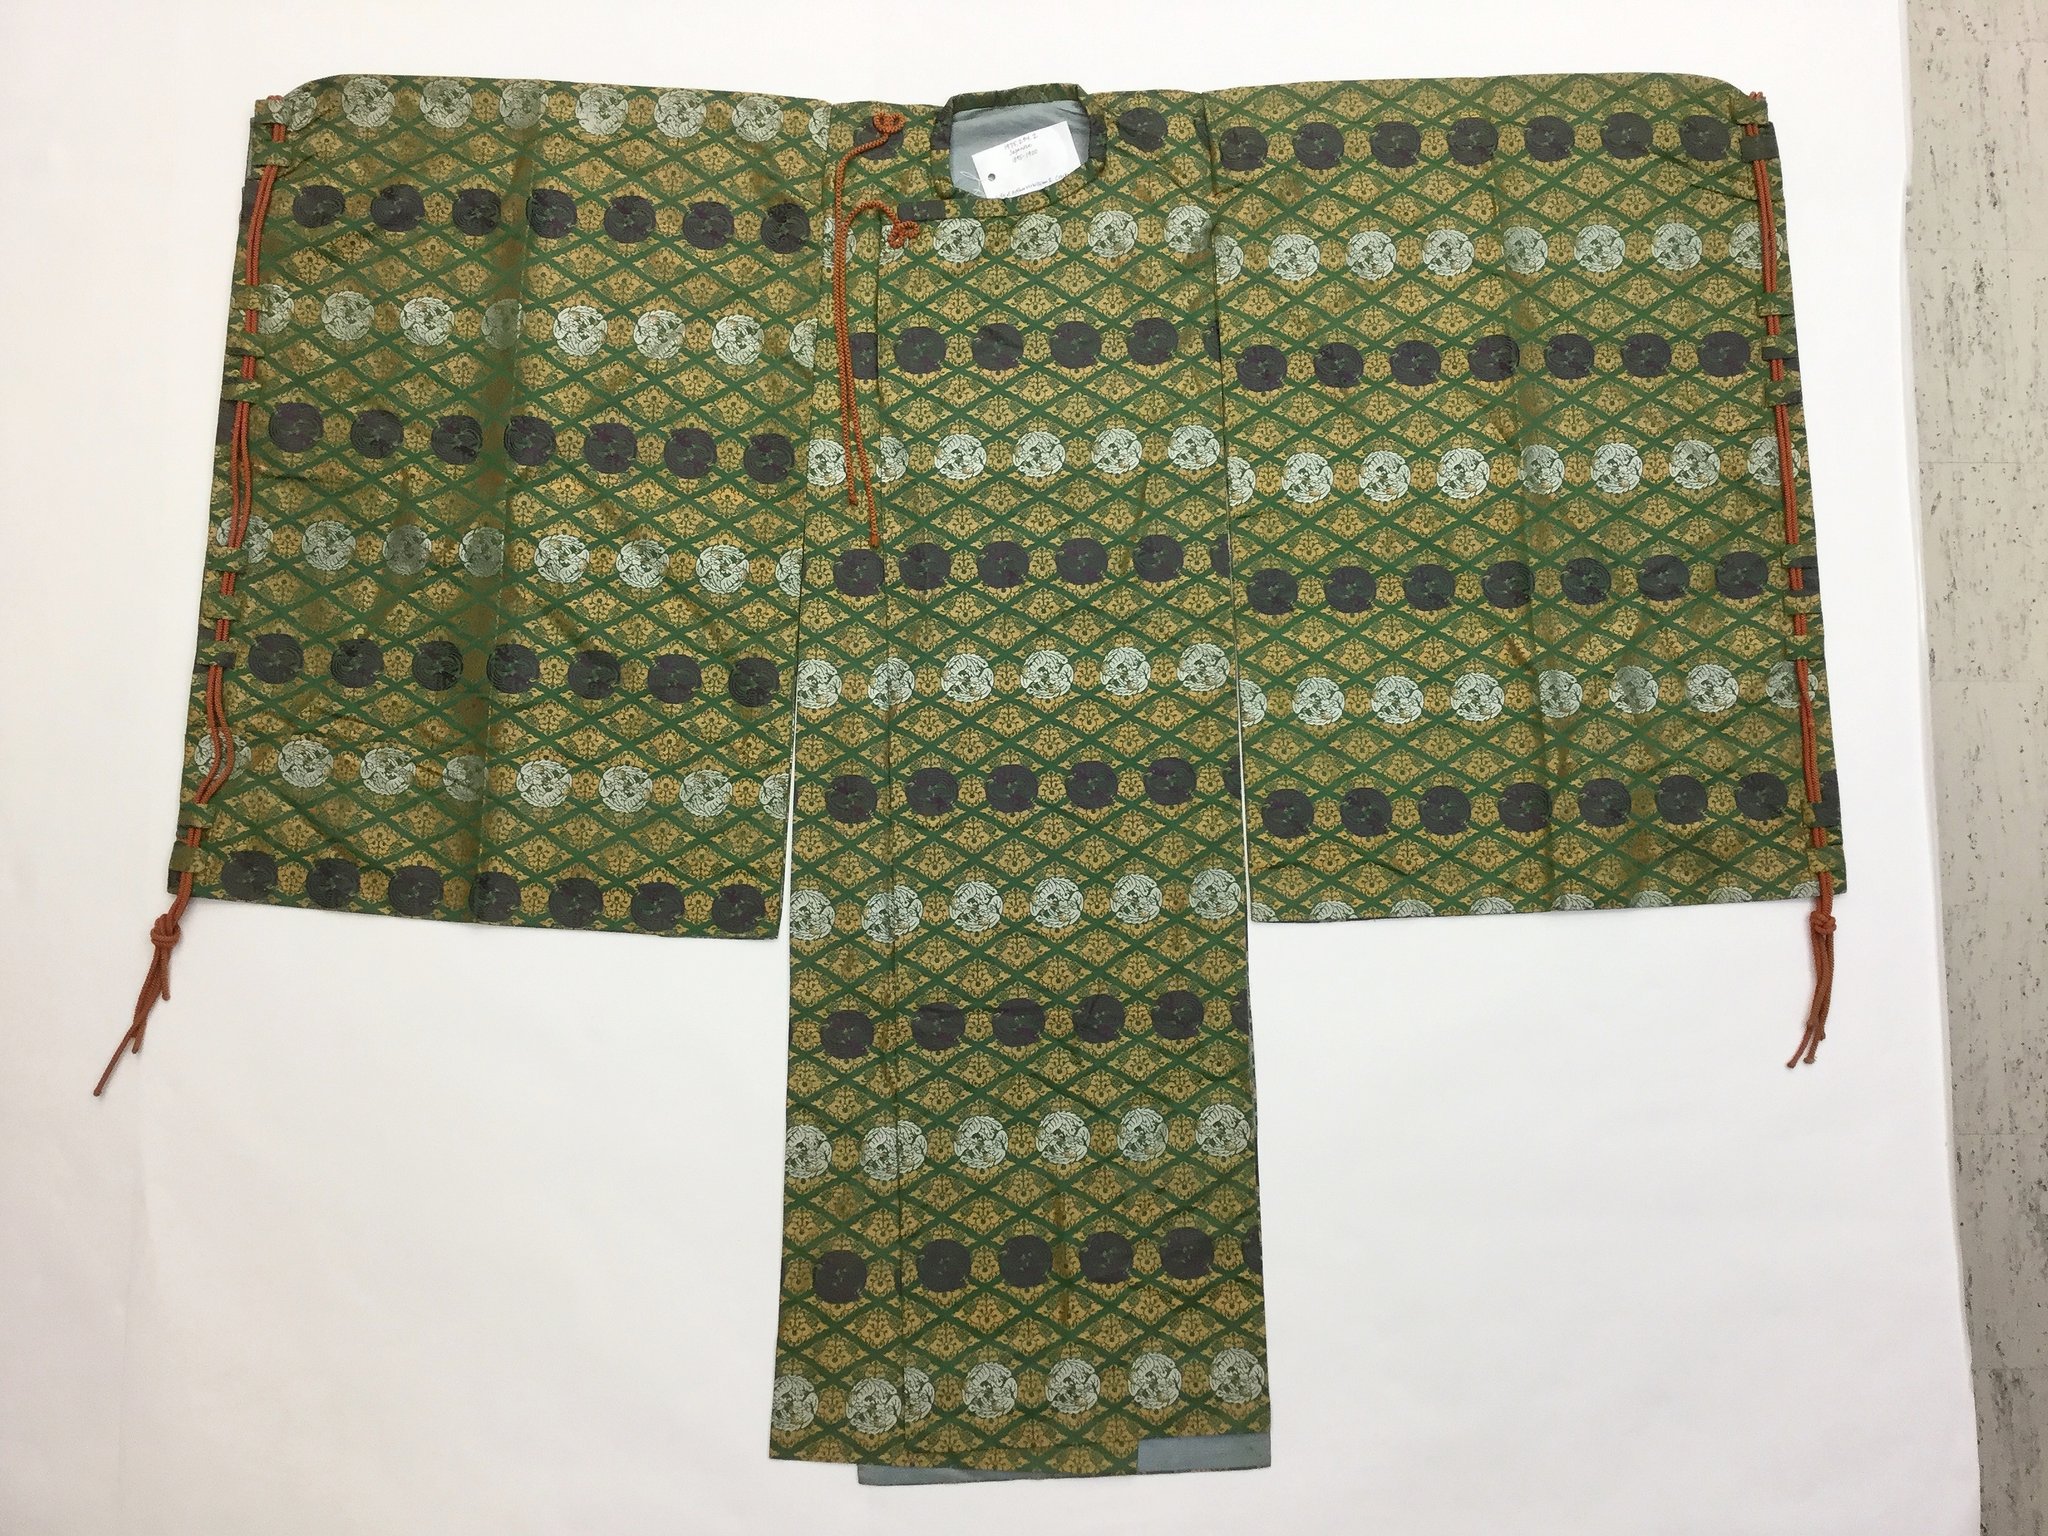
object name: kimono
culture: japanese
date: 1895-1900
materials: silk